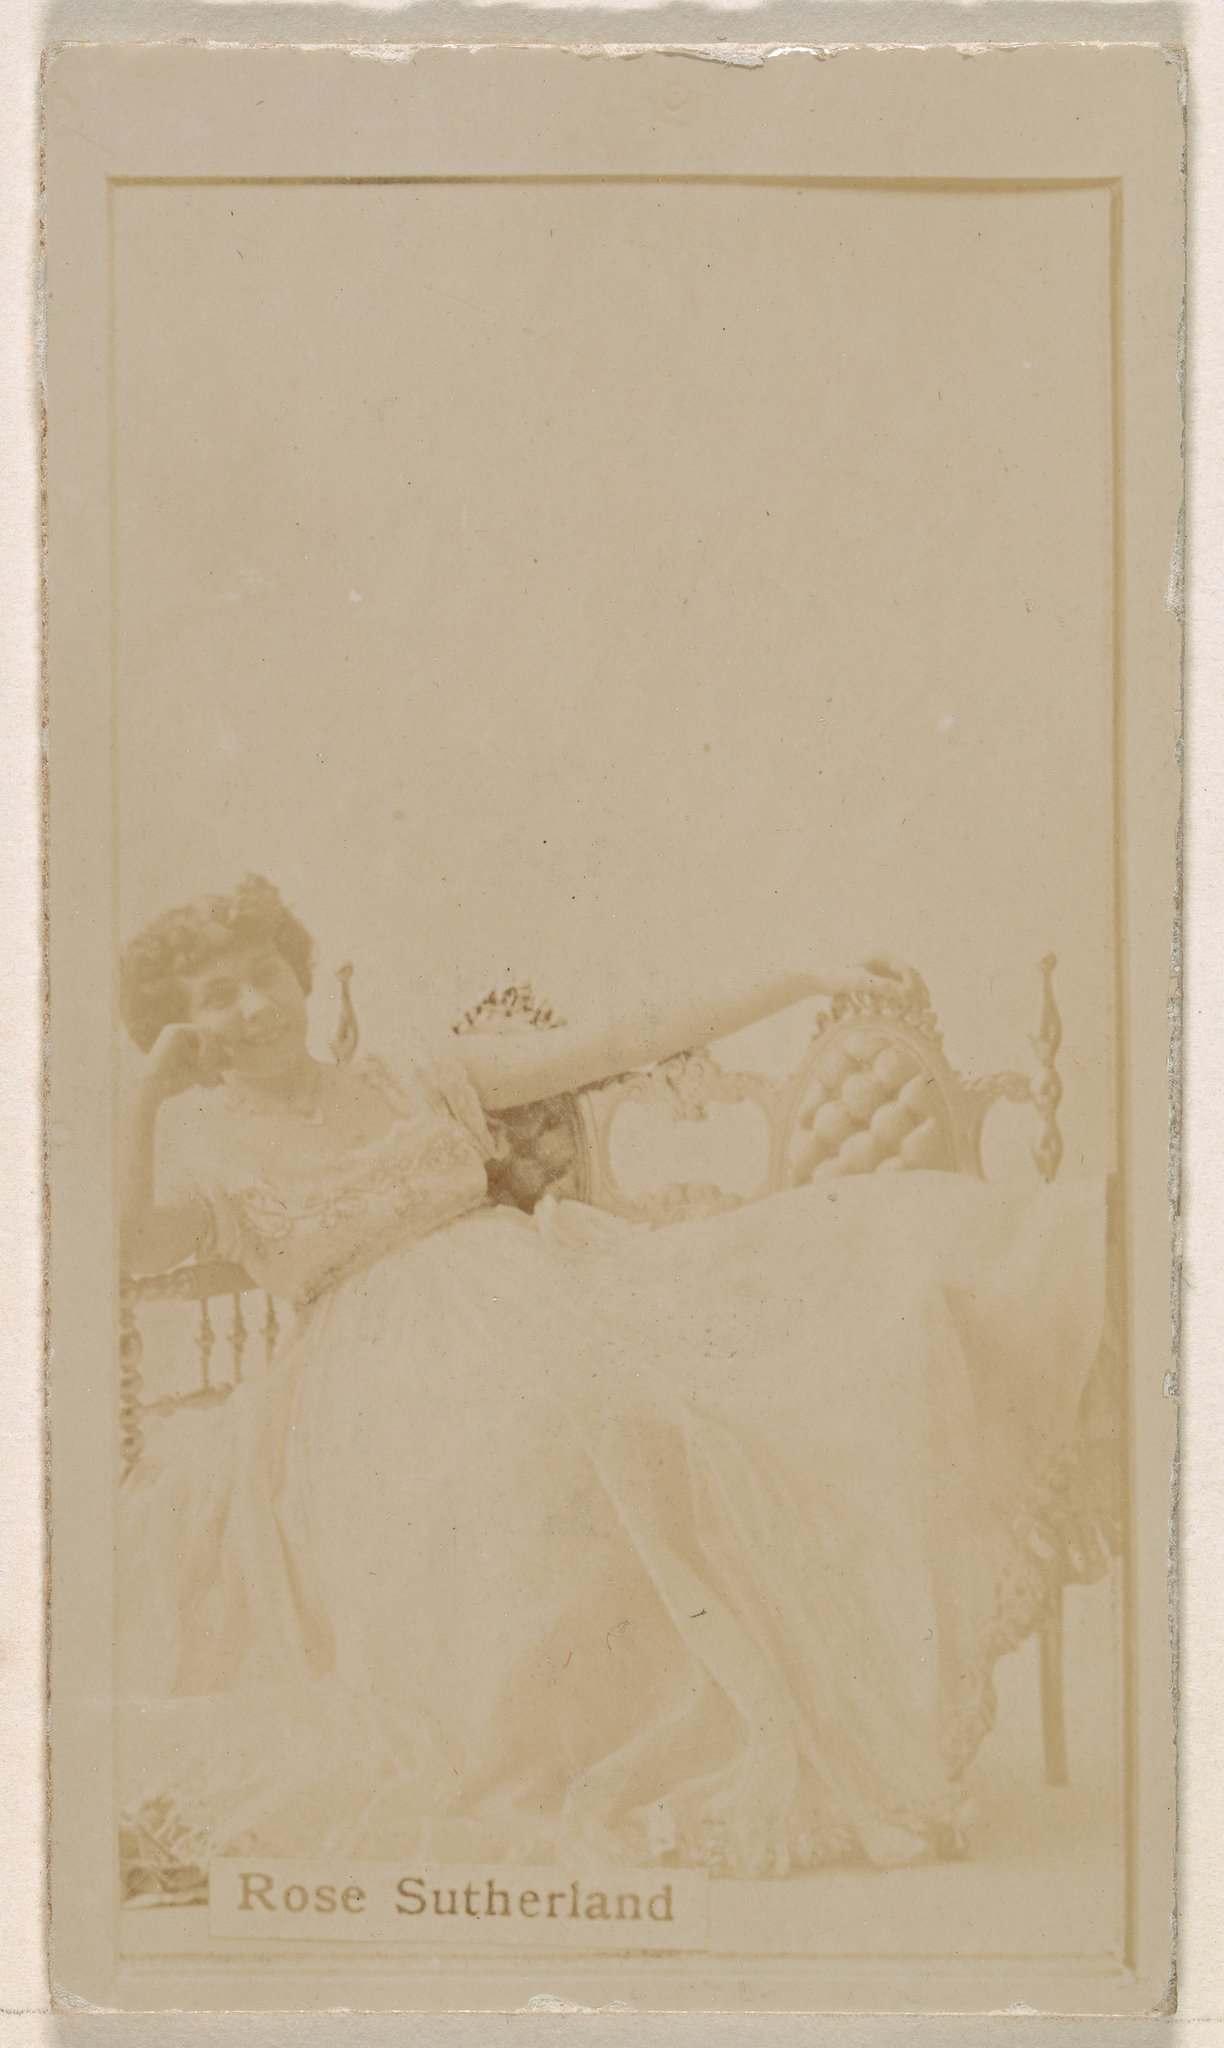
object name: photograph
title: Miss Rose Sutherland, from the Actresses series (N245) issued by Kinney Brothers to promote Sweet Caporal Cigarettes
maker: kinney brothers tobacco company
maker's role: publisher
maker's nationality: american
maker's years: 1869-2011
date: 1890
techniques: albumen silver print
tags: portraits,women,actresses